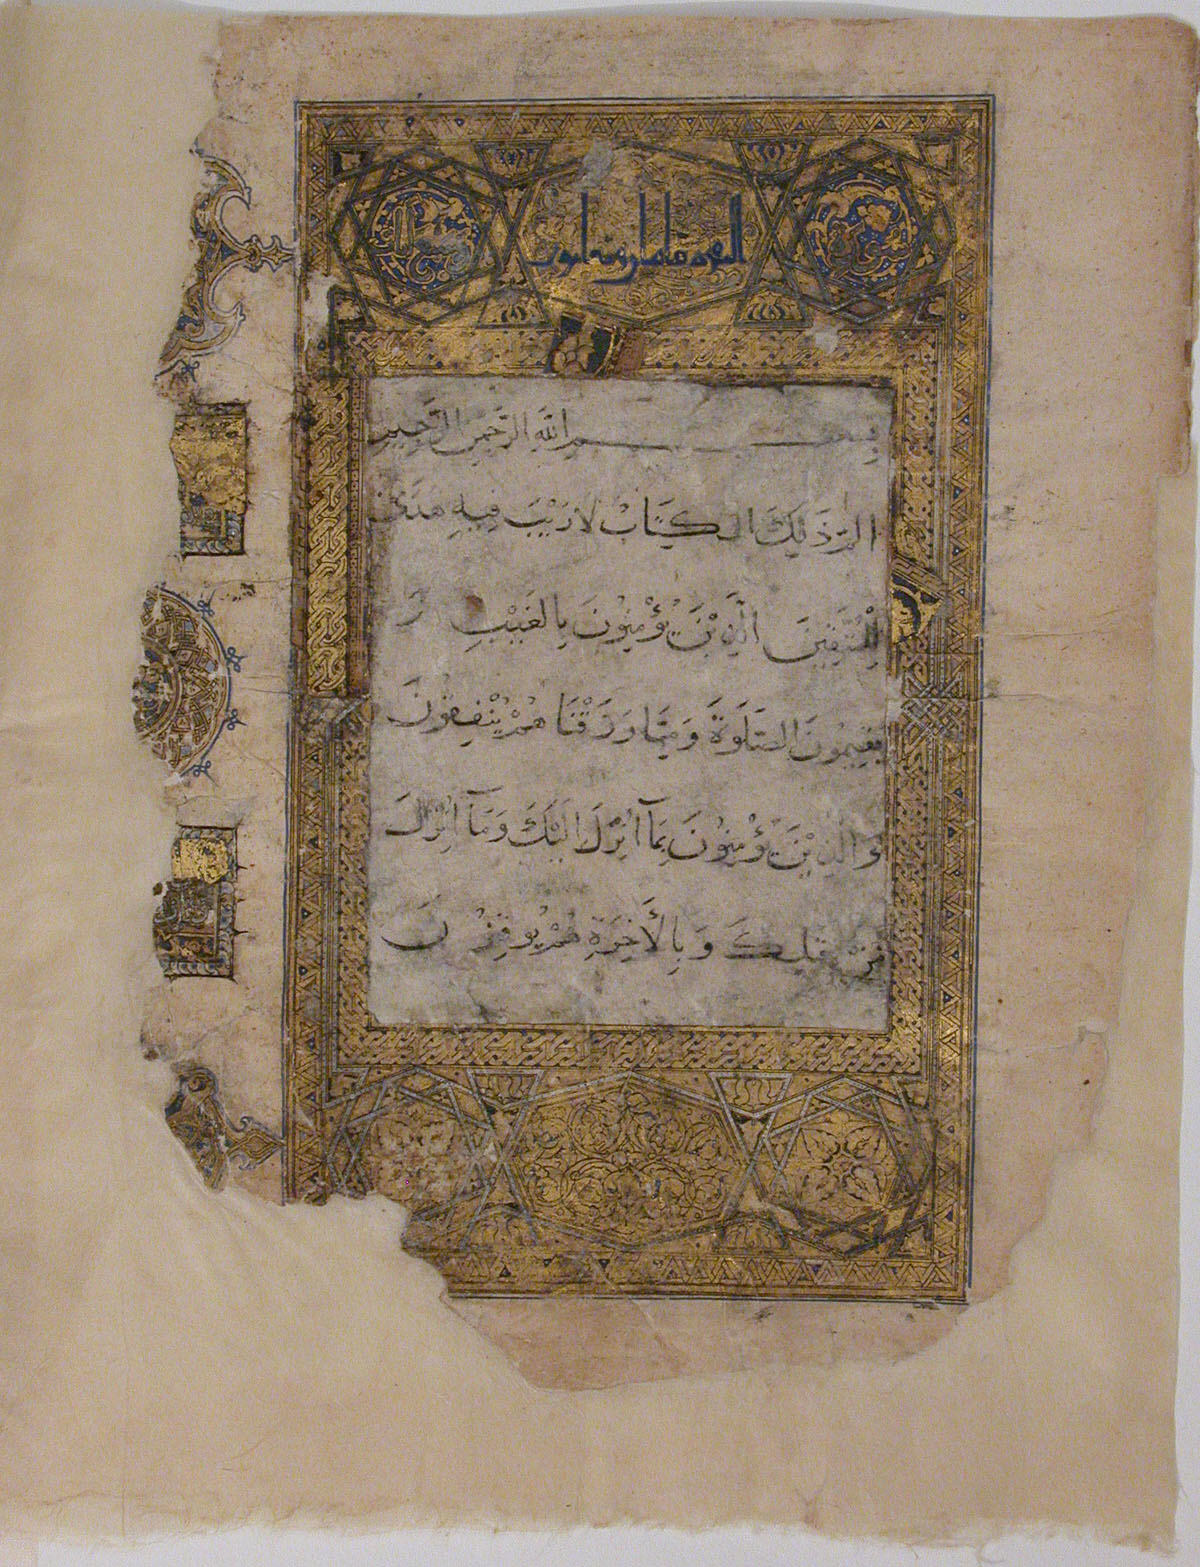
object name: folio from a non illustrated manuscript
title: Folio from a Qur'an Manuscript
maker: muhammad al-zanjani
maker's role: calligrapher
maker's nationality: iranian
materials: gold, ink, paper, watercolor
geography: iran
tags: qur'an